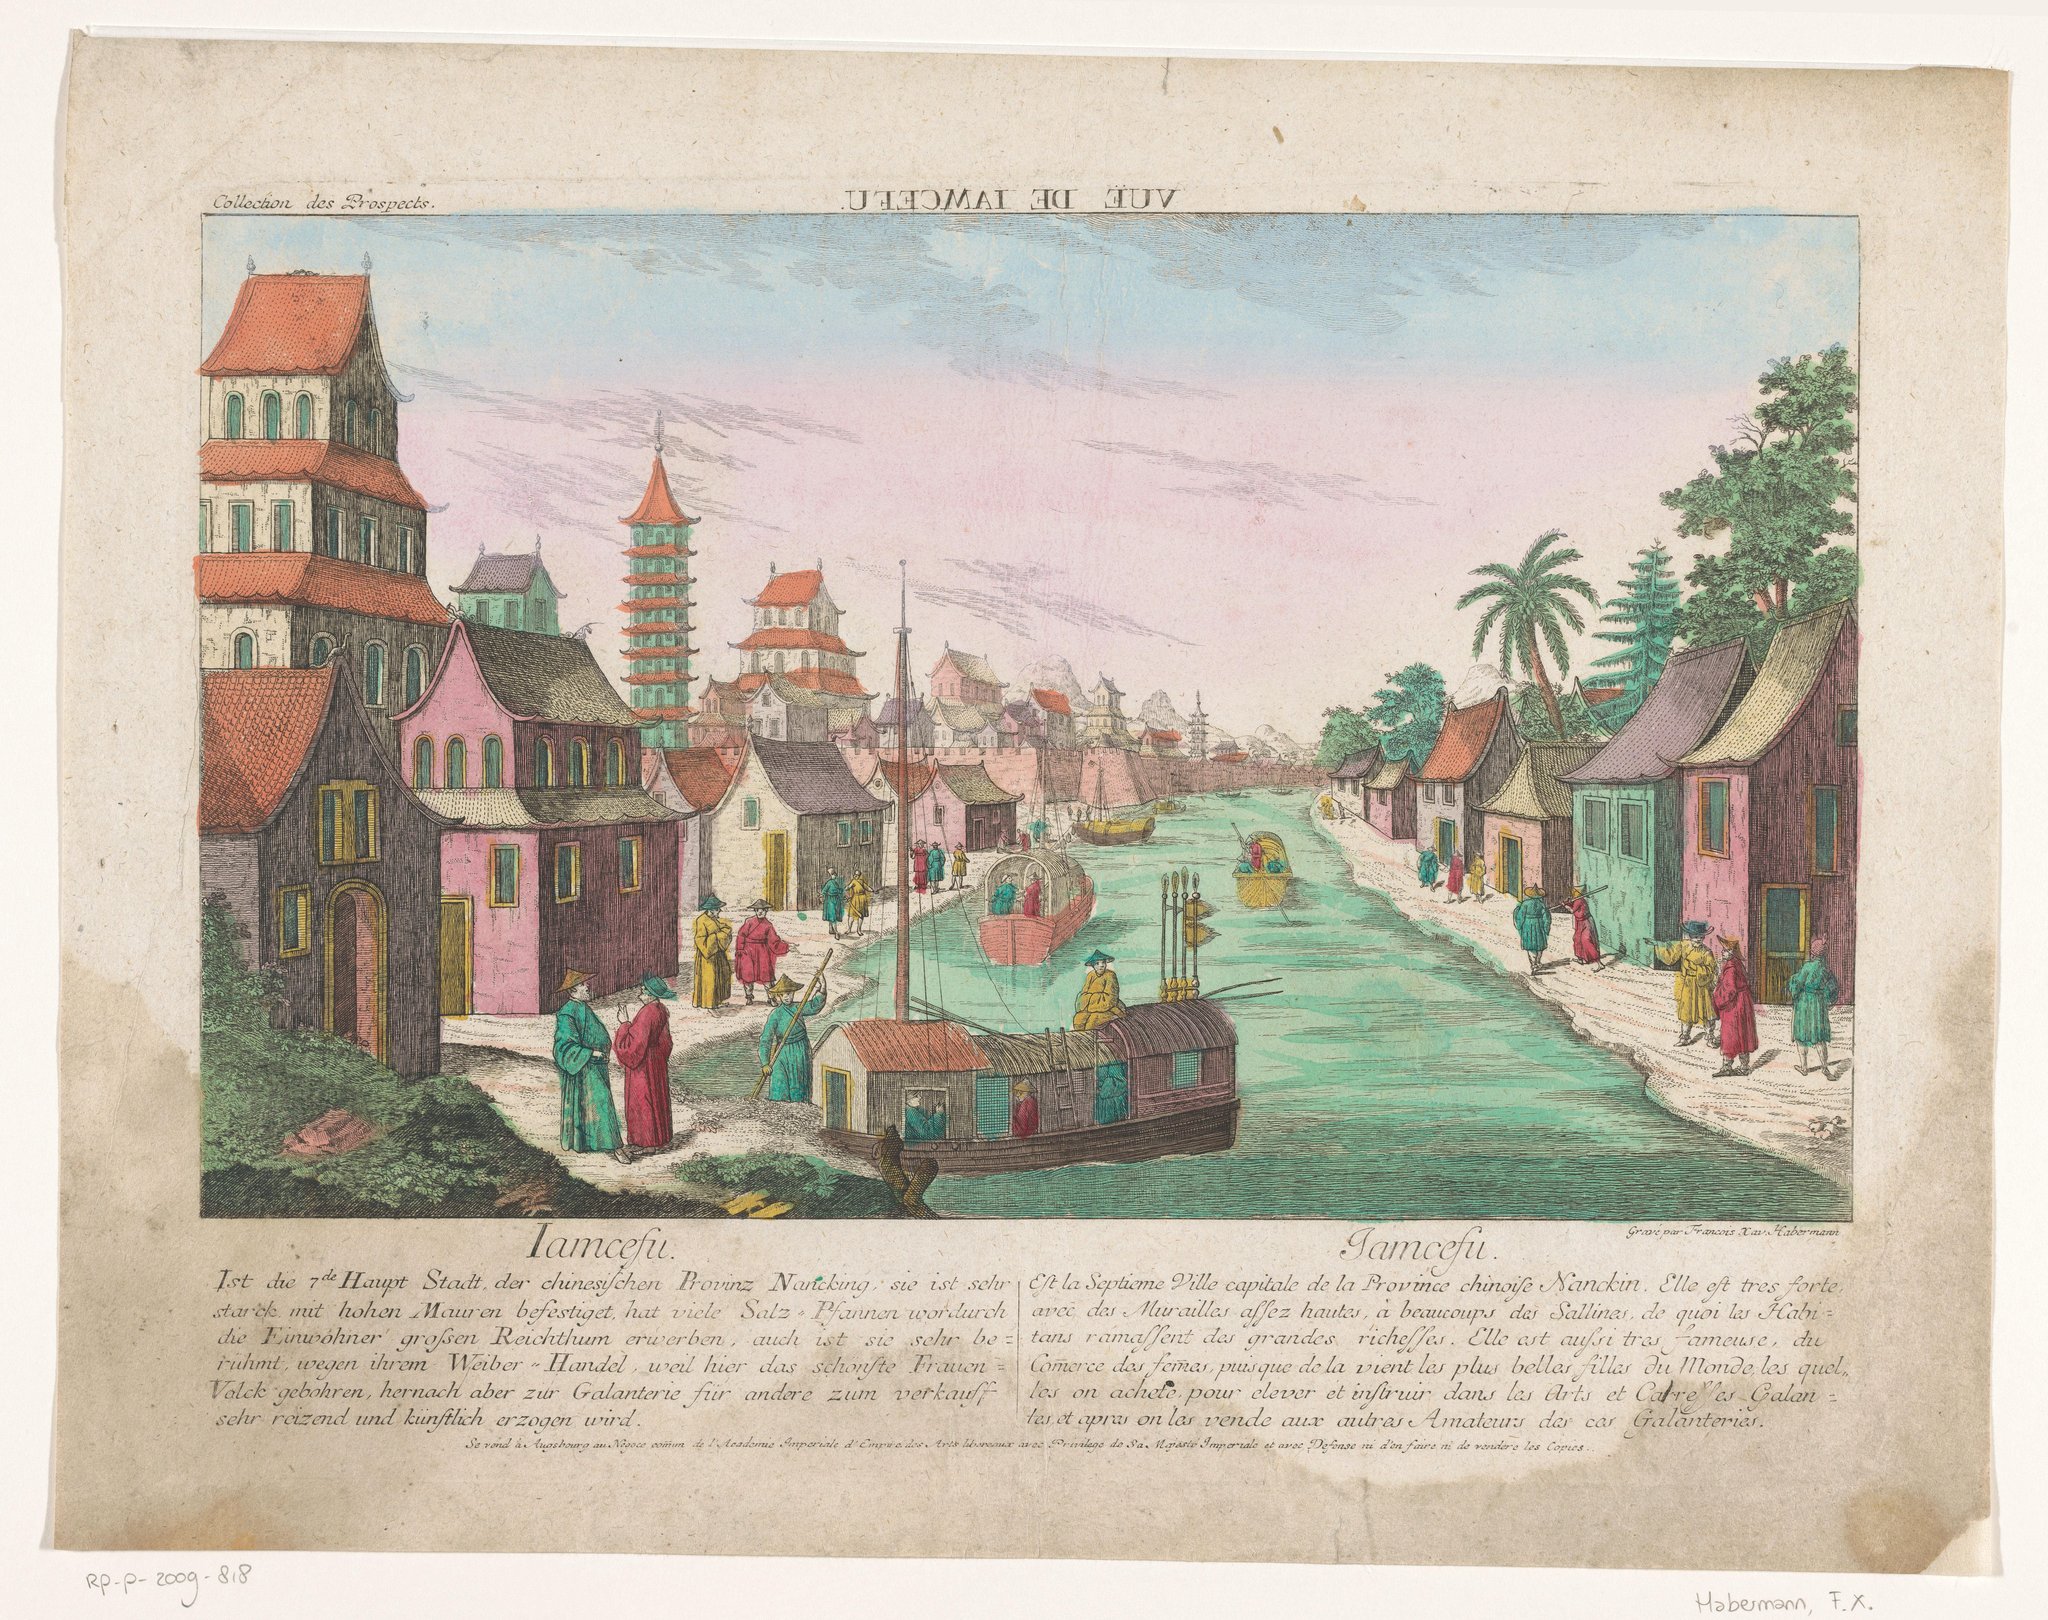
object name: print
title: Iamcefu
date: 1755-1779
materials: paper, watercolor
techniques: brush, etching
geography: augsburg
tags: china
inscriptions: collector's mark: Lugt 2228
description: Gezicht op een rivier met enkele schepen. Op de linkeroever vrijstaande gebouwen waarachter een toren, op de rechter oever kleinere gebouwen, daarachter bomen. Langs het water figuren. Onder de prent een beschrijving in het Duits en het Frans.